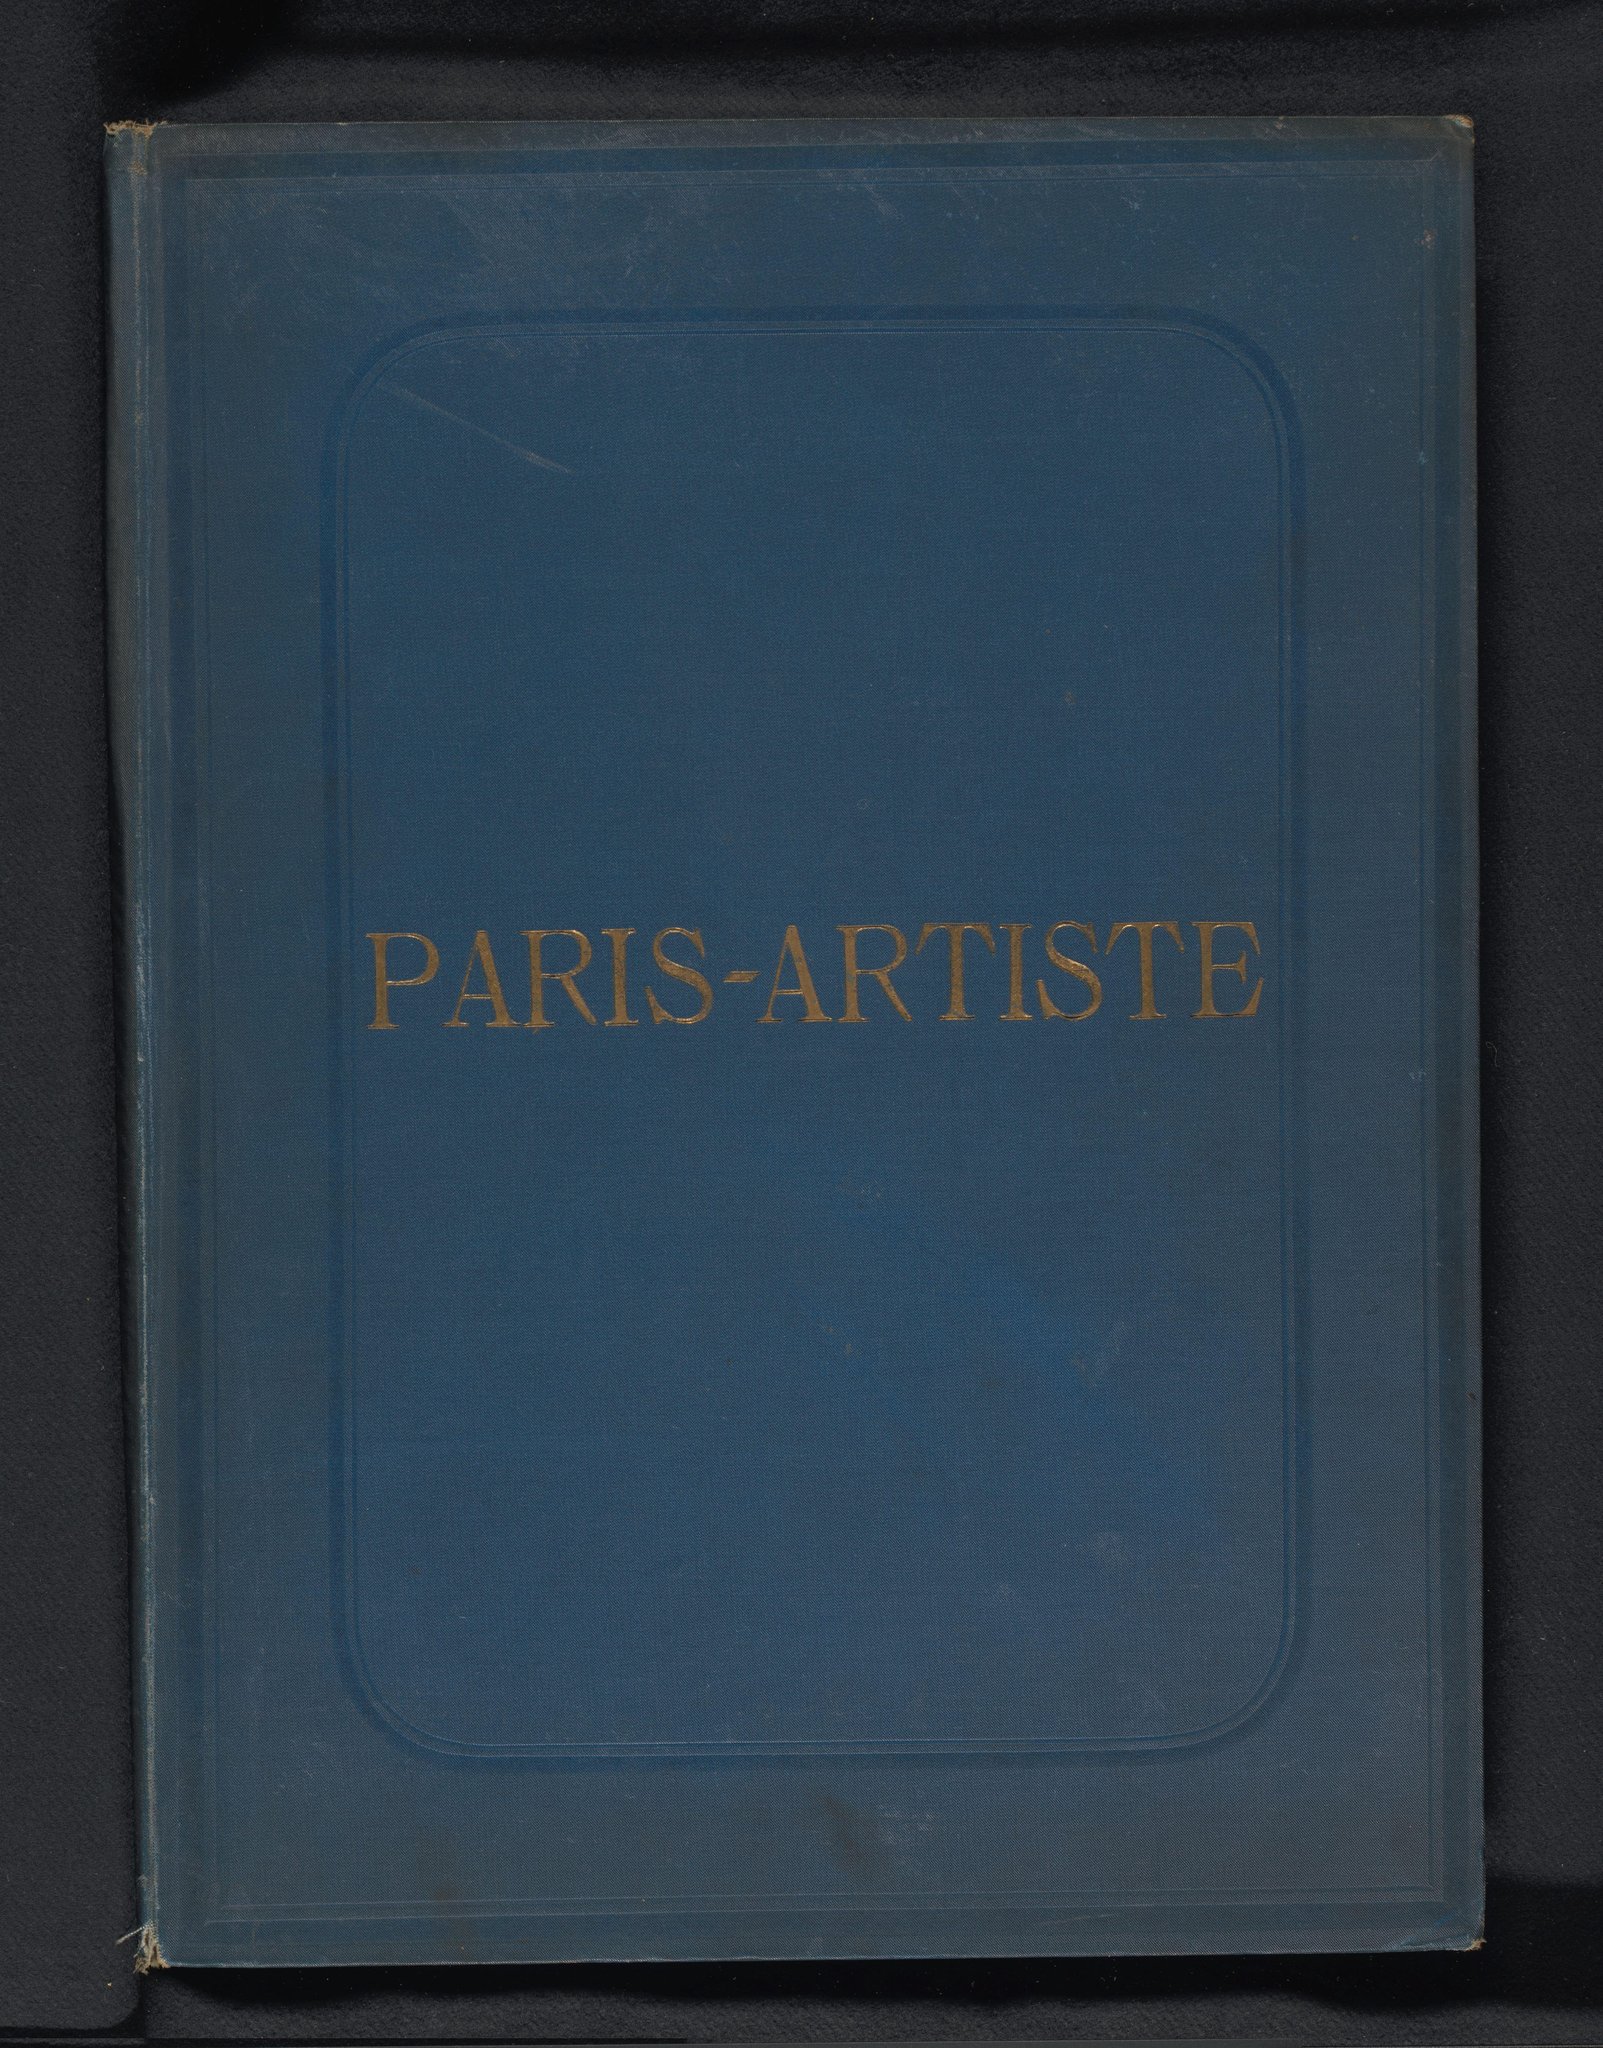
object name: magazine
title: Paris-artiste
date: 1883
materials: cardboard, paper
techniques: photograph, lithograph, printing, printing block, woodburytype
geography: paris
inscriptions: annotation: ‘37 fotos/ nog 52 71 ontbreken’, number: ‘H4615’